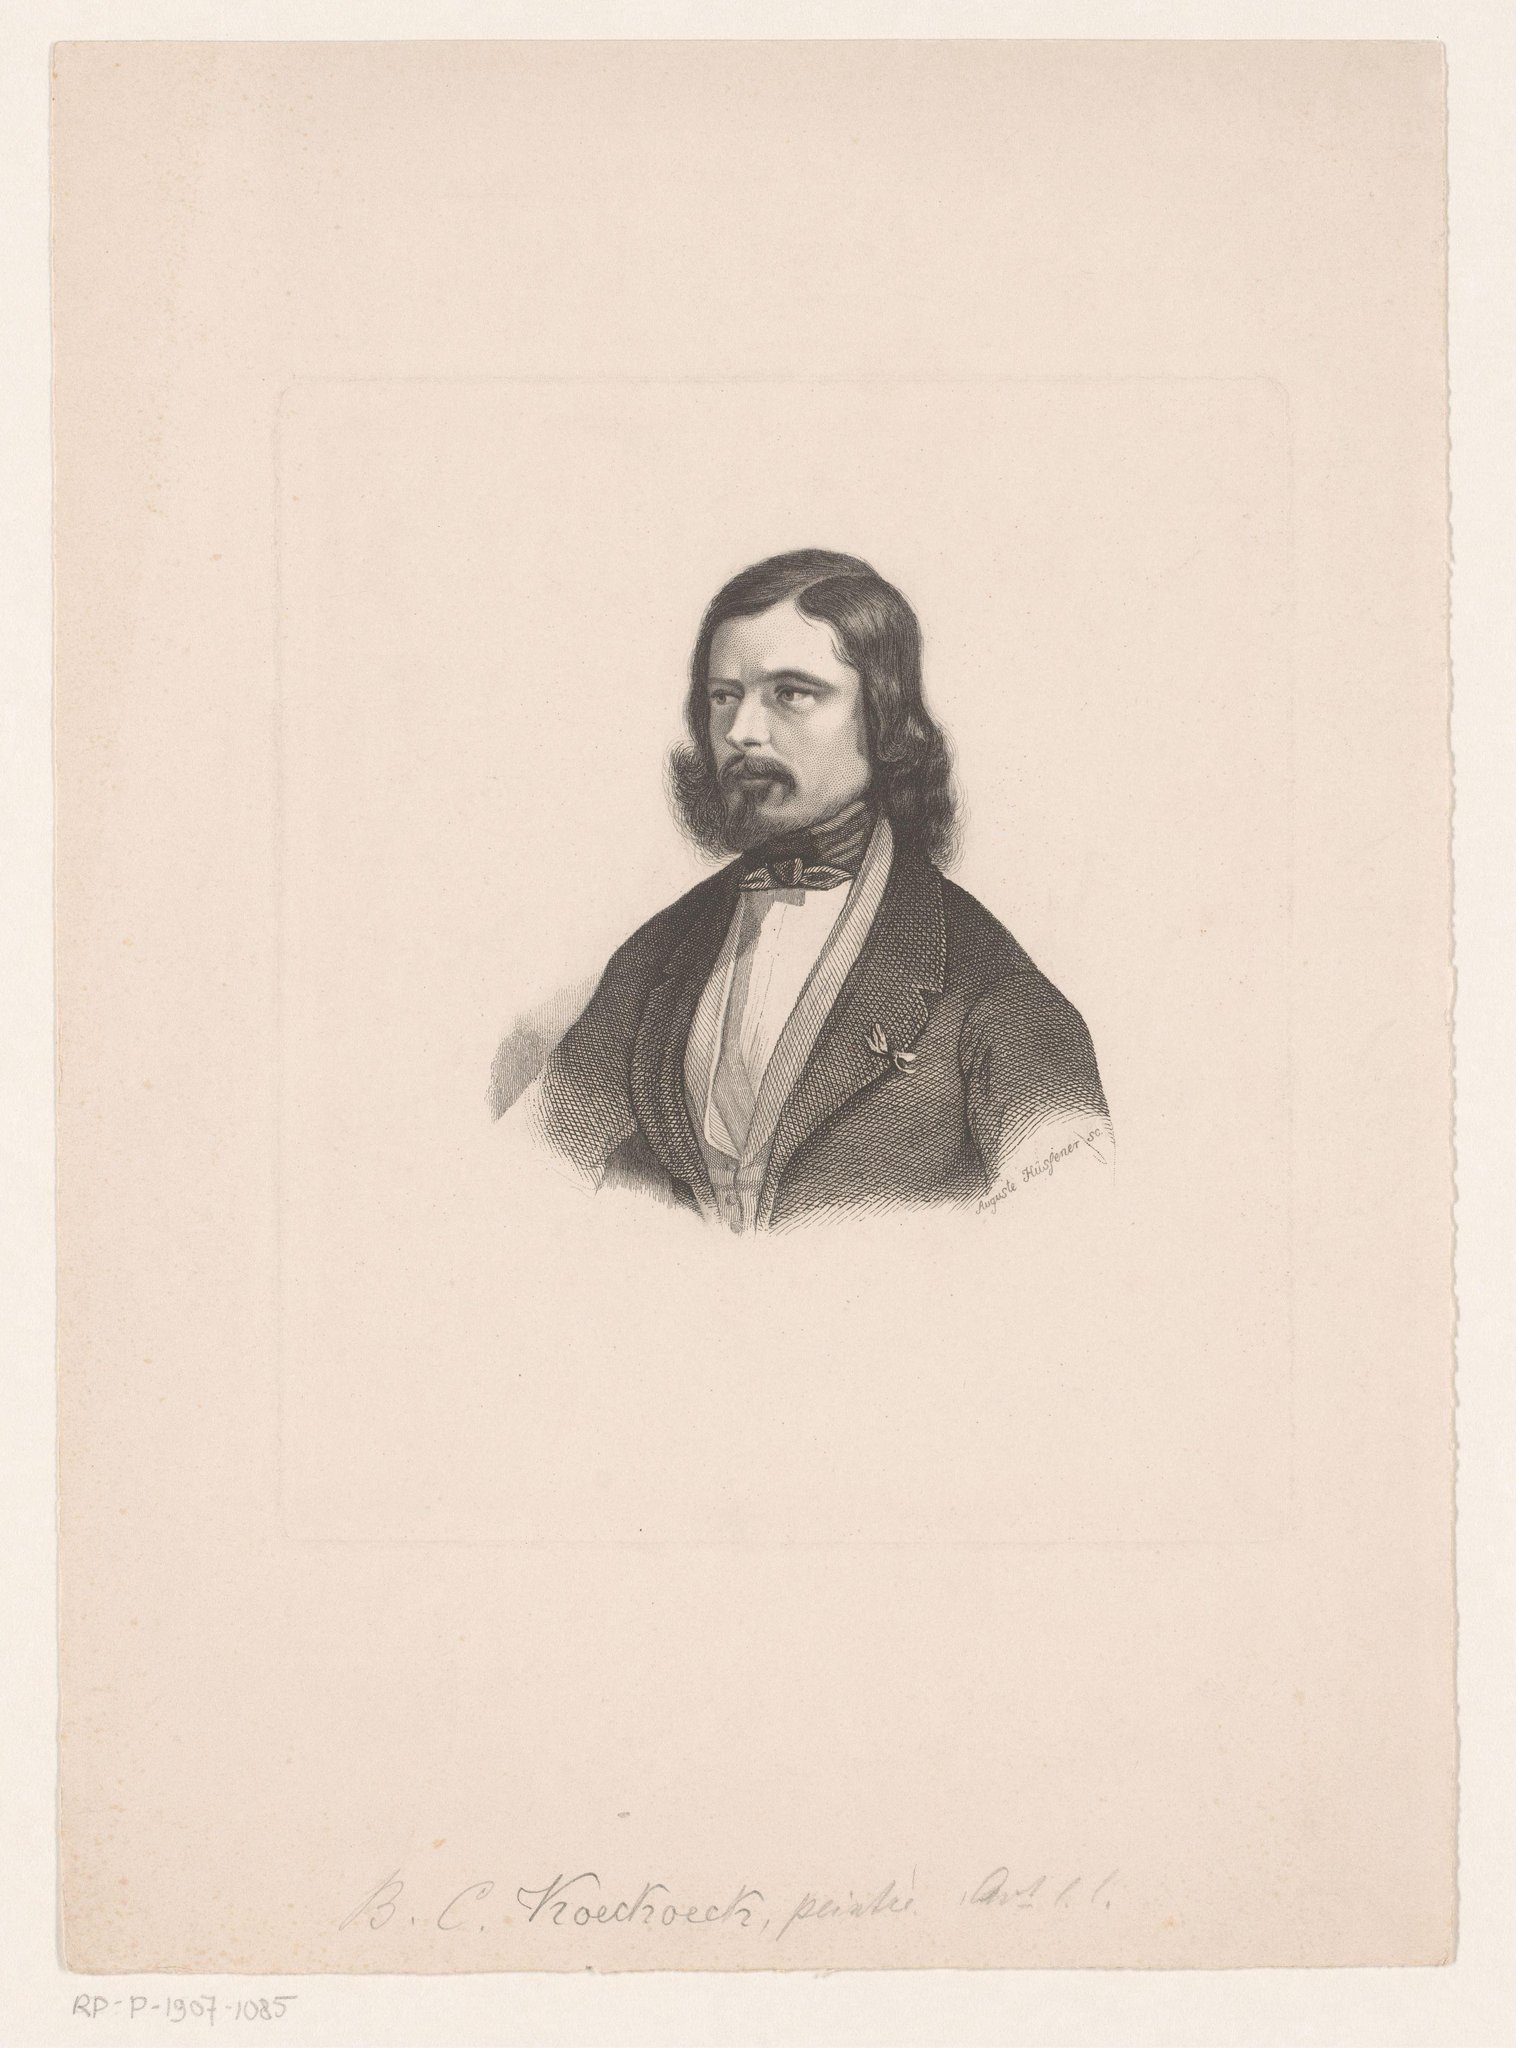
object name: print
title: Portret van Barend Cornelis Koekkoek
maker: auguste hüssener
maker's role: print maker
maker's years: 1789-1877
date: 1813-1877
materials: paper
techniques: etching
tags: middelburg, cleves, painter, print maker, draughtsman, barend cornelis koekkoek, historical persons, portrait, self-portrait of painter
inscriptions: collector's mark: Lugt 2228